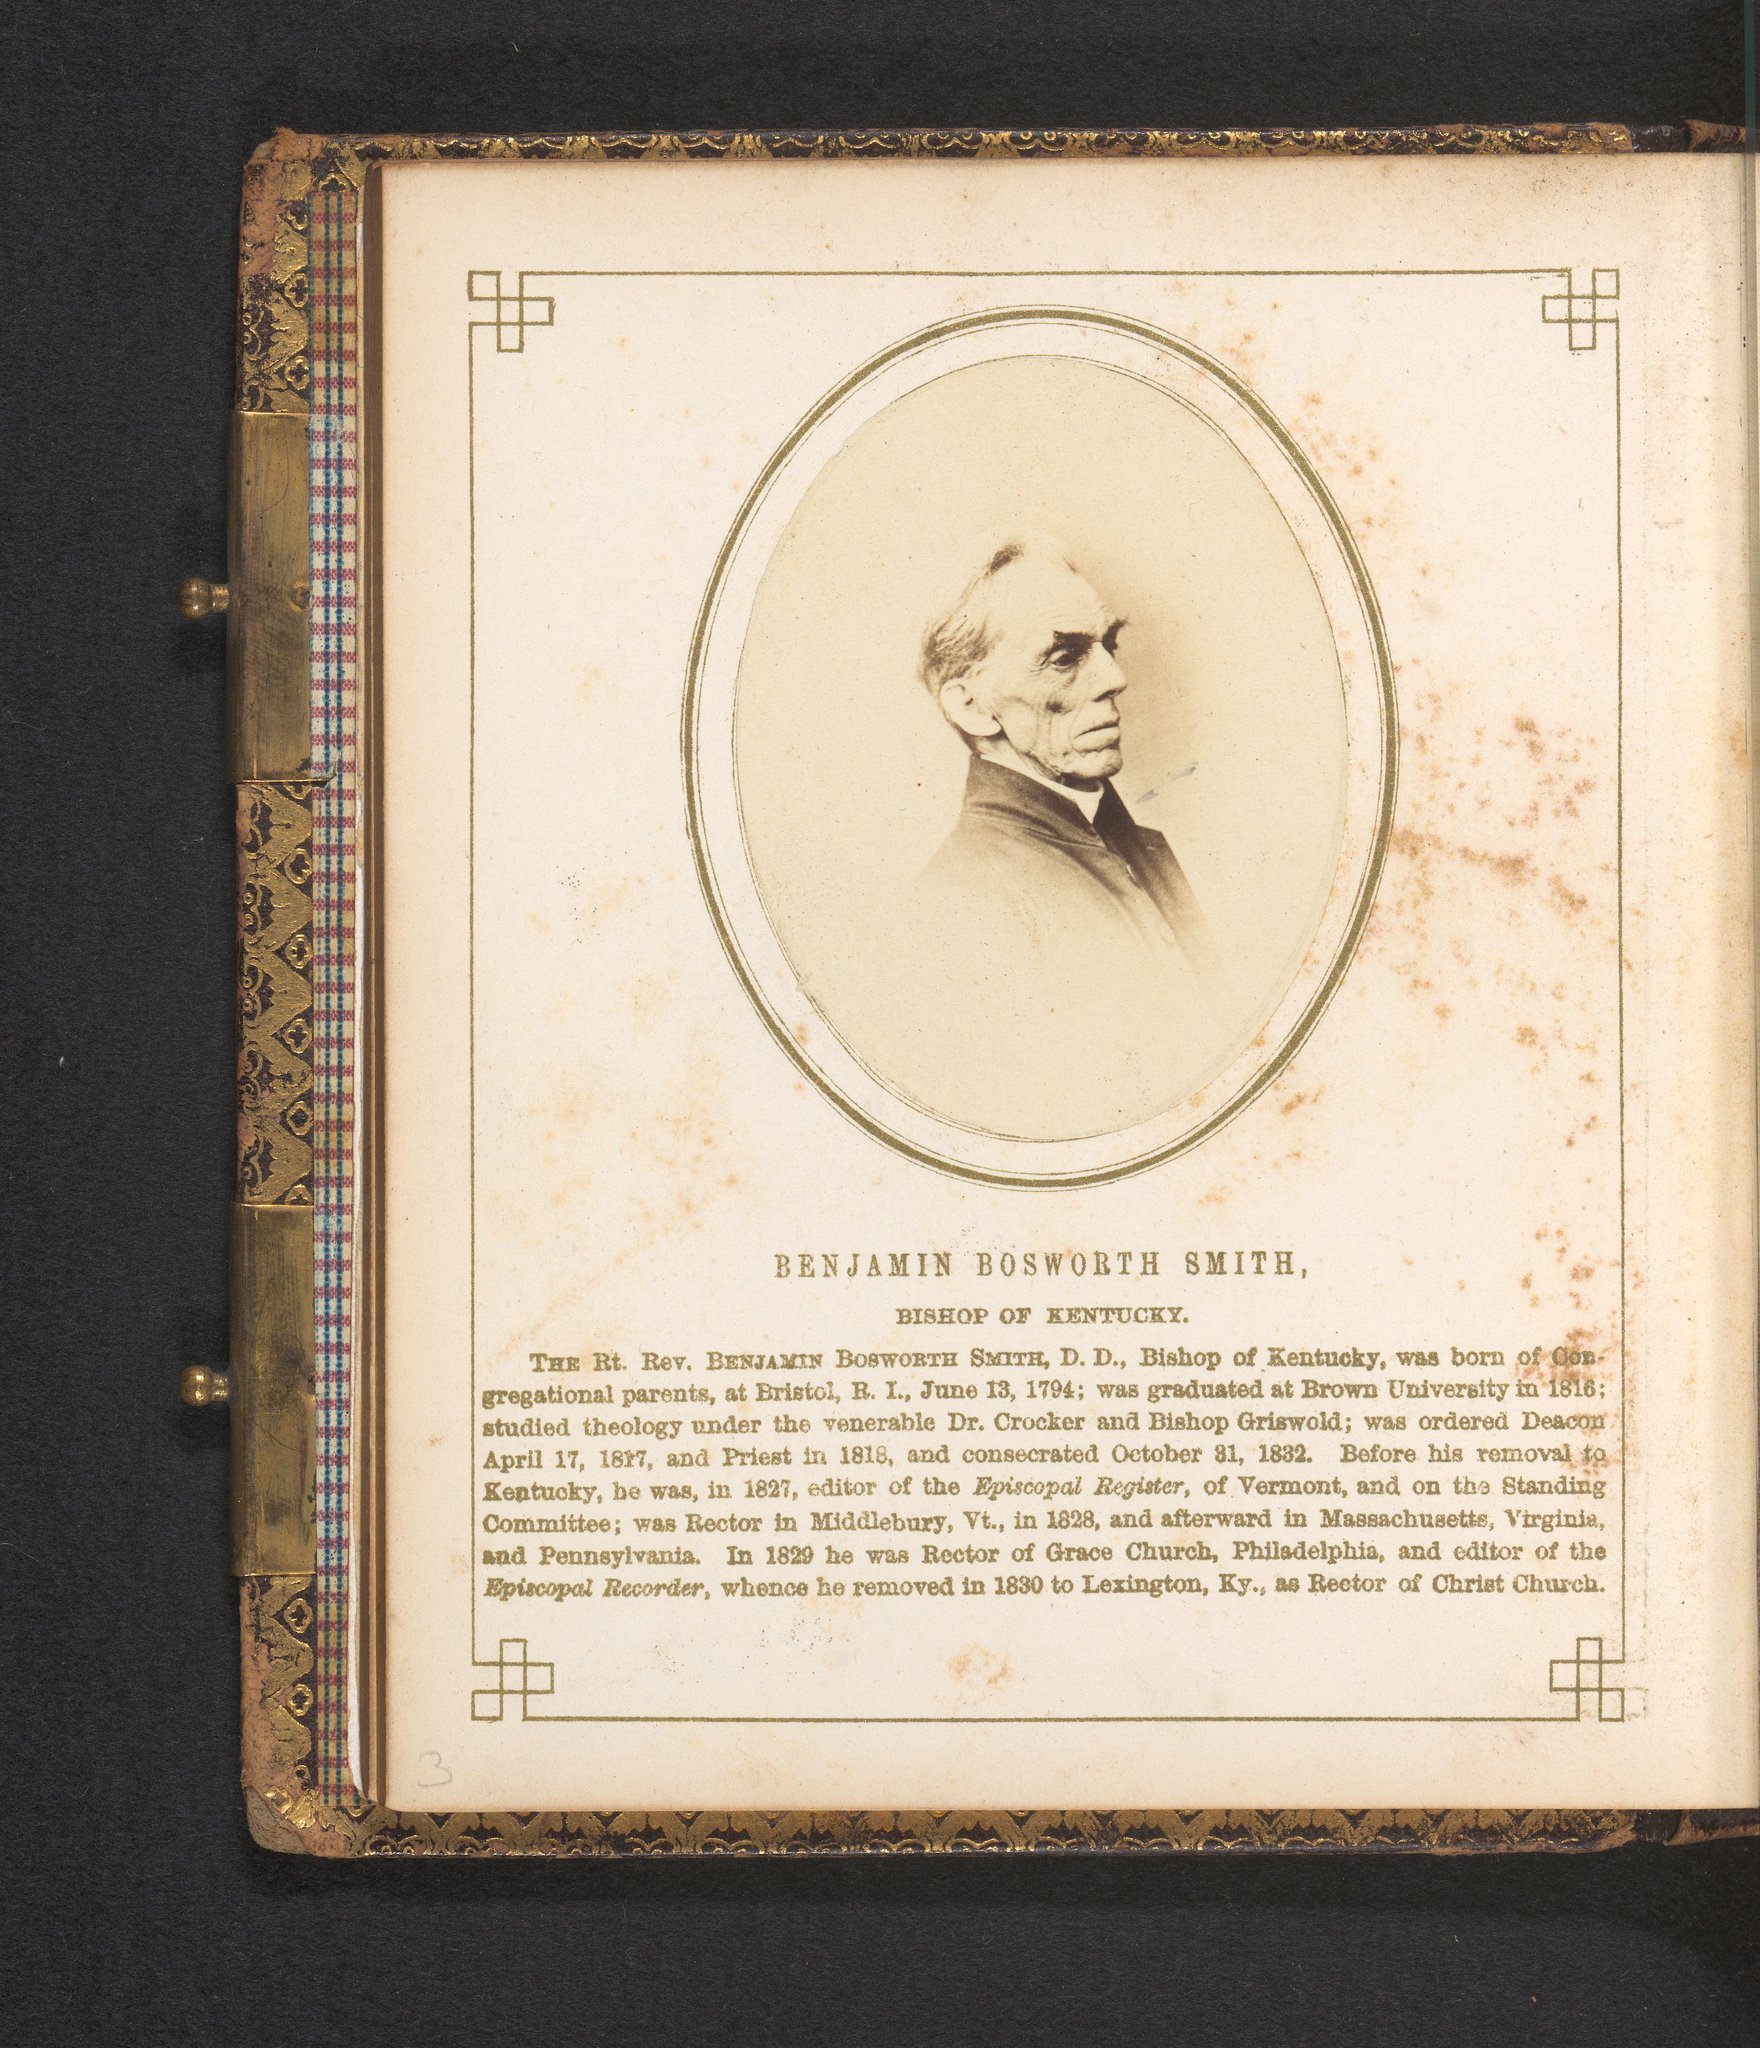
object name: photograph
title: Portret van Benjamin Bosworth Smith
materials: photographic support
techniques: albumen print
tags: bristol (rhode island), historical persons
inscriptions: inscription: ‘Benjamin Bosworth Smith/ Bishop of Kentucky/ (...)’